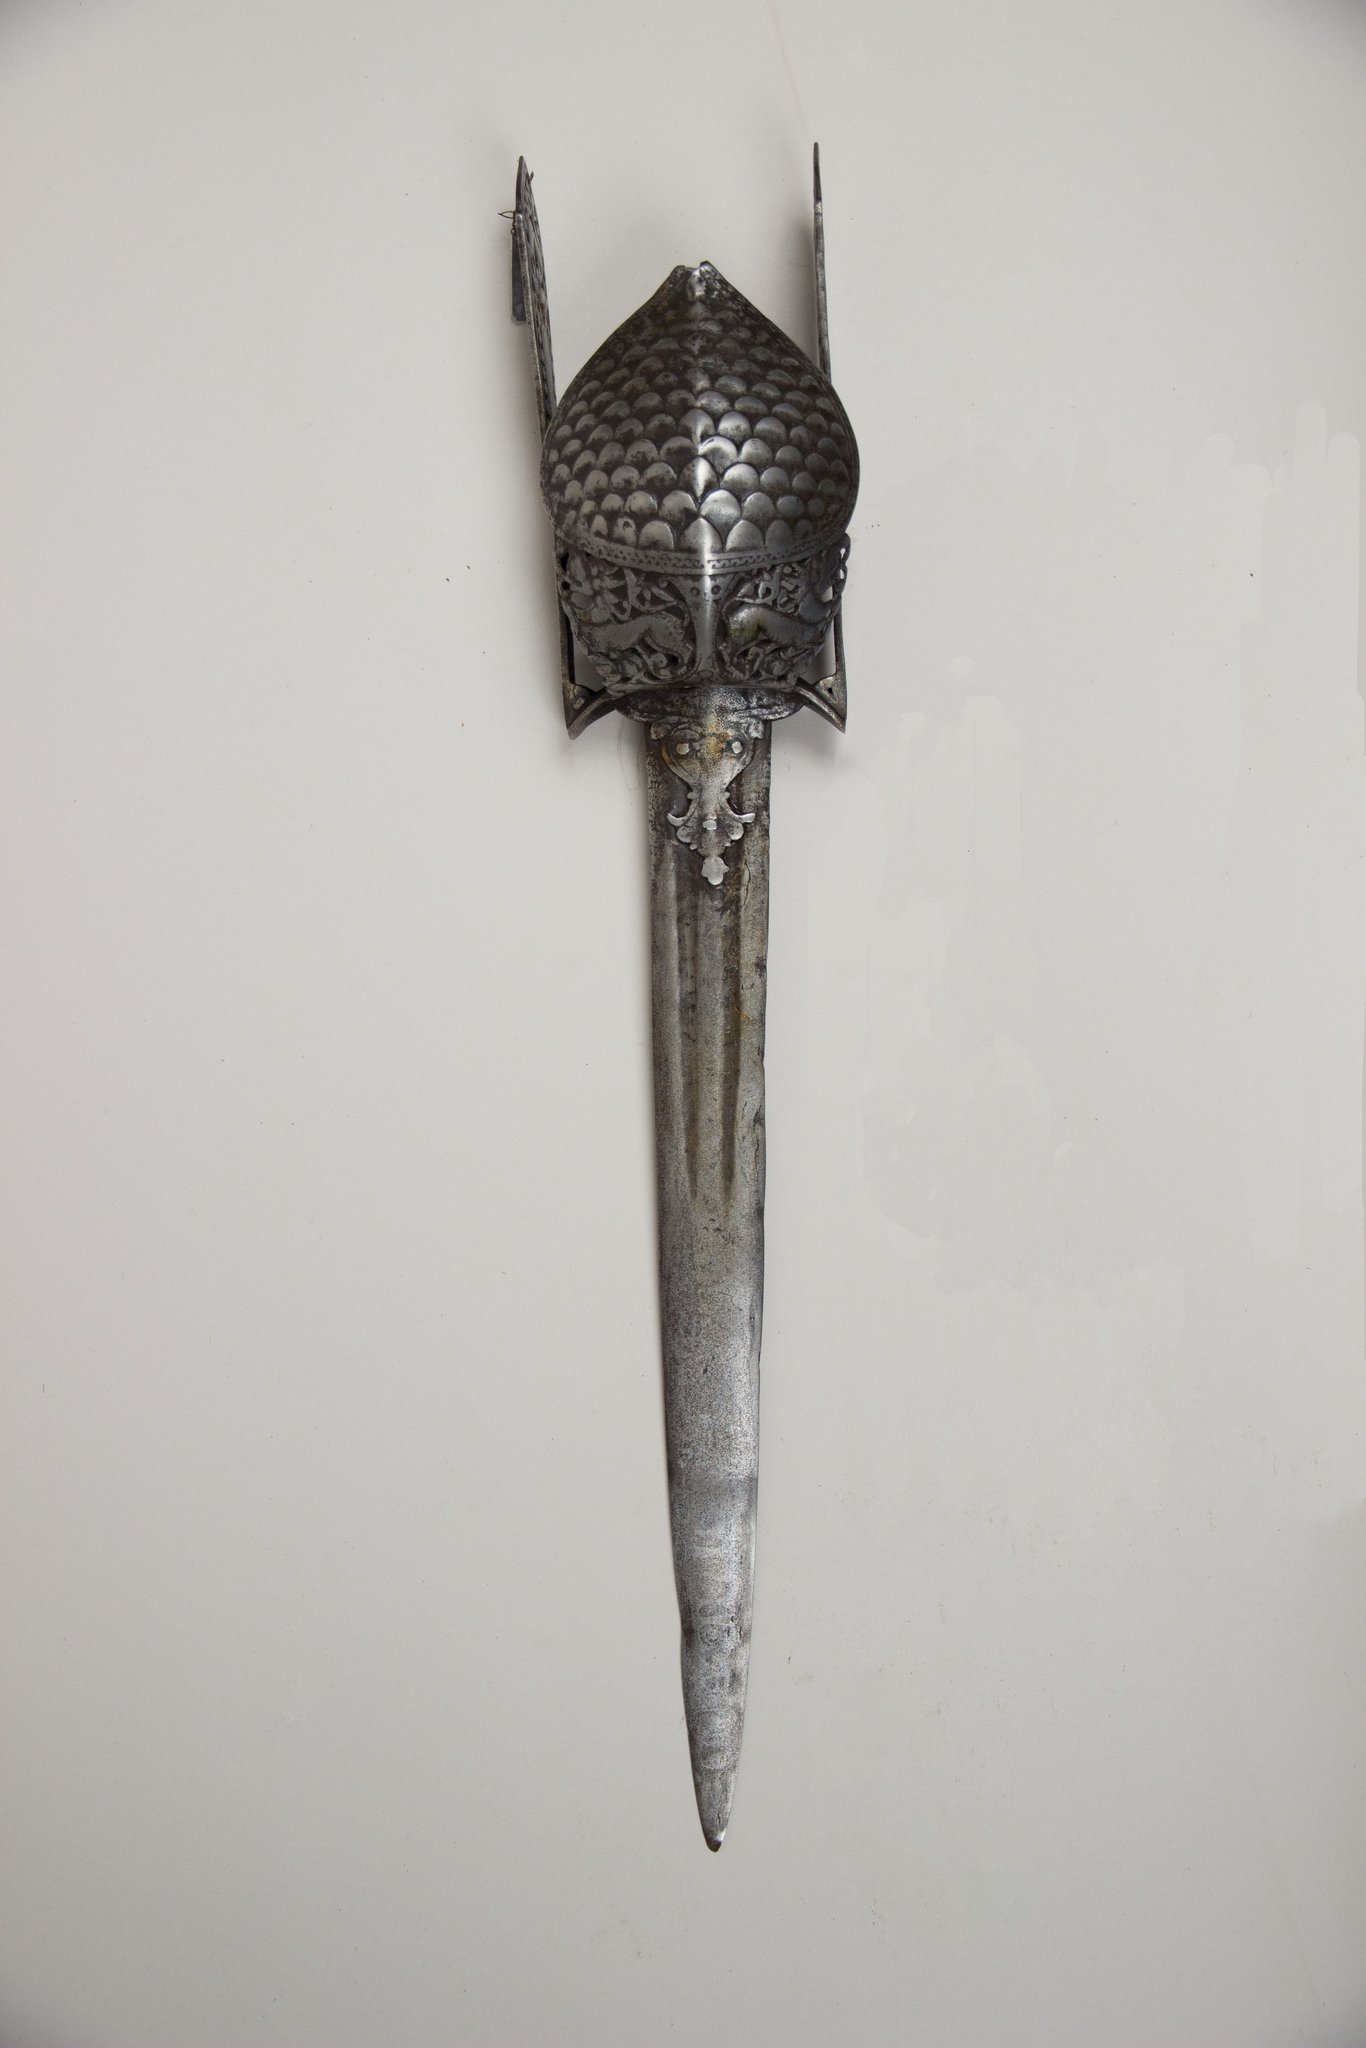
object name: dagger katar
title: Guarded Dagger (Katar)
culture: indian, thanjavur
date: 1601-1700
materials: steel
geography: india